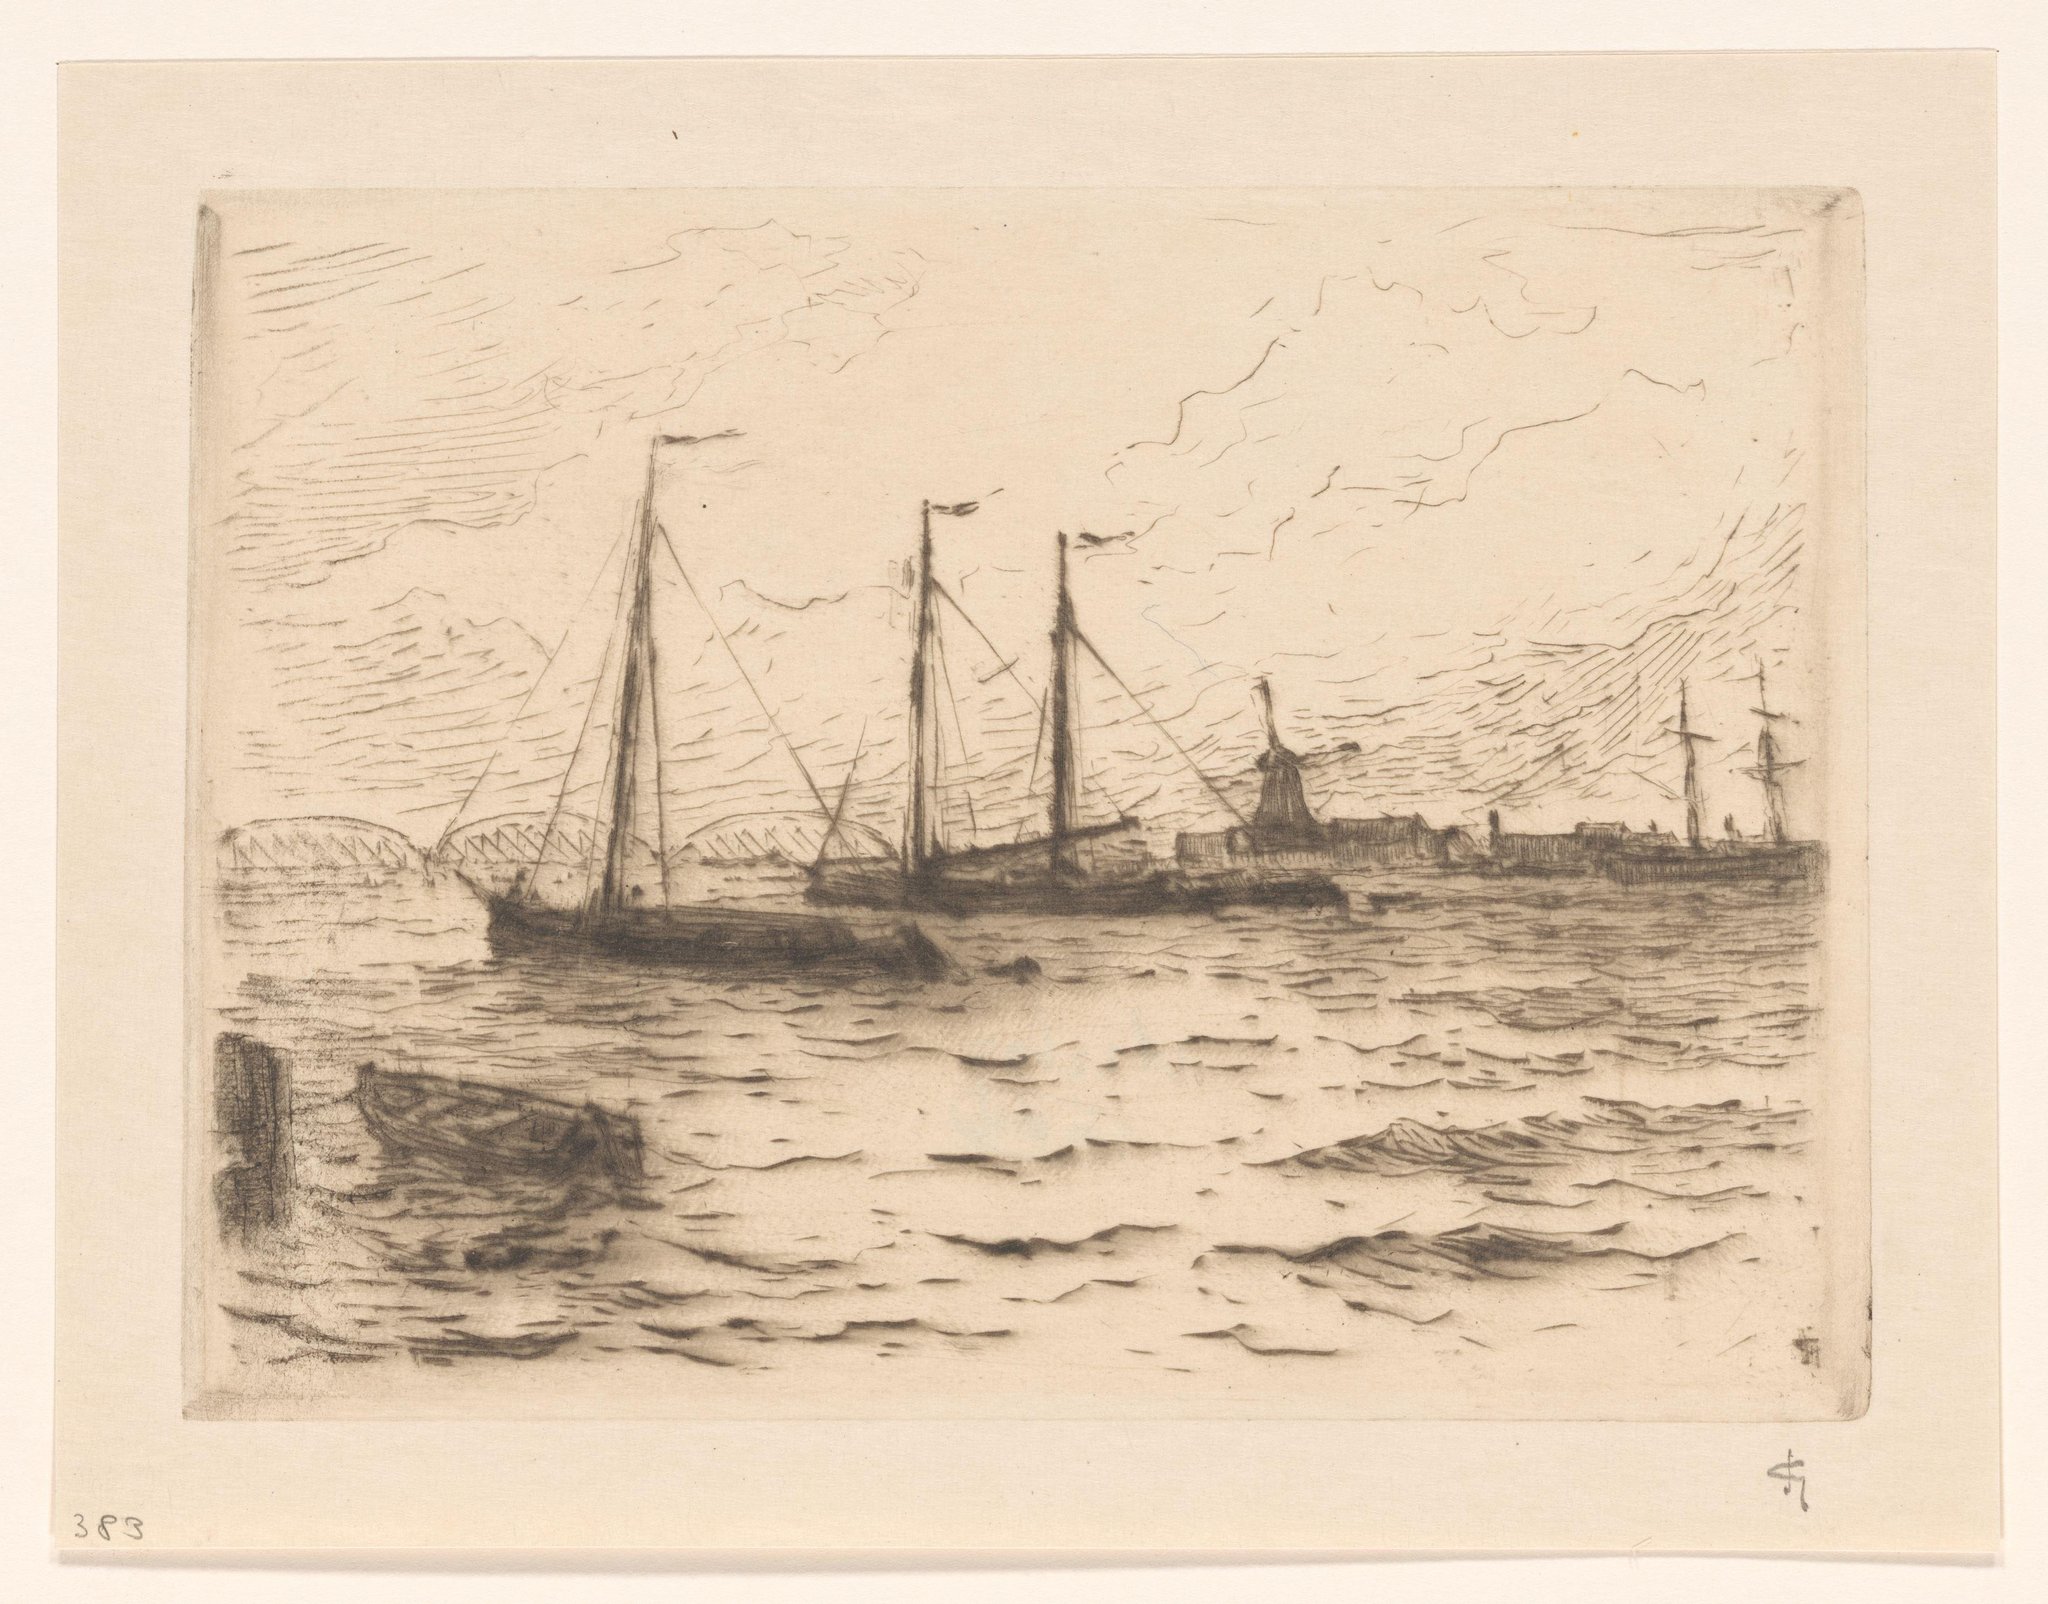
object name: print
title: Riviergezicht met spoorbrug bij Dordrecht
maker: carel nicolaas storm van s-gravesande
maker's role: draughtsman, print maker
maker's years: 1841-1924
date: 1889-1902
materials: paper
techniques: drypoint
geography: netherlands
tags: railway-traffic, river, bridge, dordrecht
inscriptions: number: ‘383’, collector's mark: Lugt 2228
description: Mogelijk vermeld in: Storm van 's-Gravesande, Charles. Catalogue des eaux-fortes et lithographies. New York: s.n., 1903, of in een onbekende latere uitgave van het manuscript. Vermoedelijk vermeld als catalogusnummer 383.